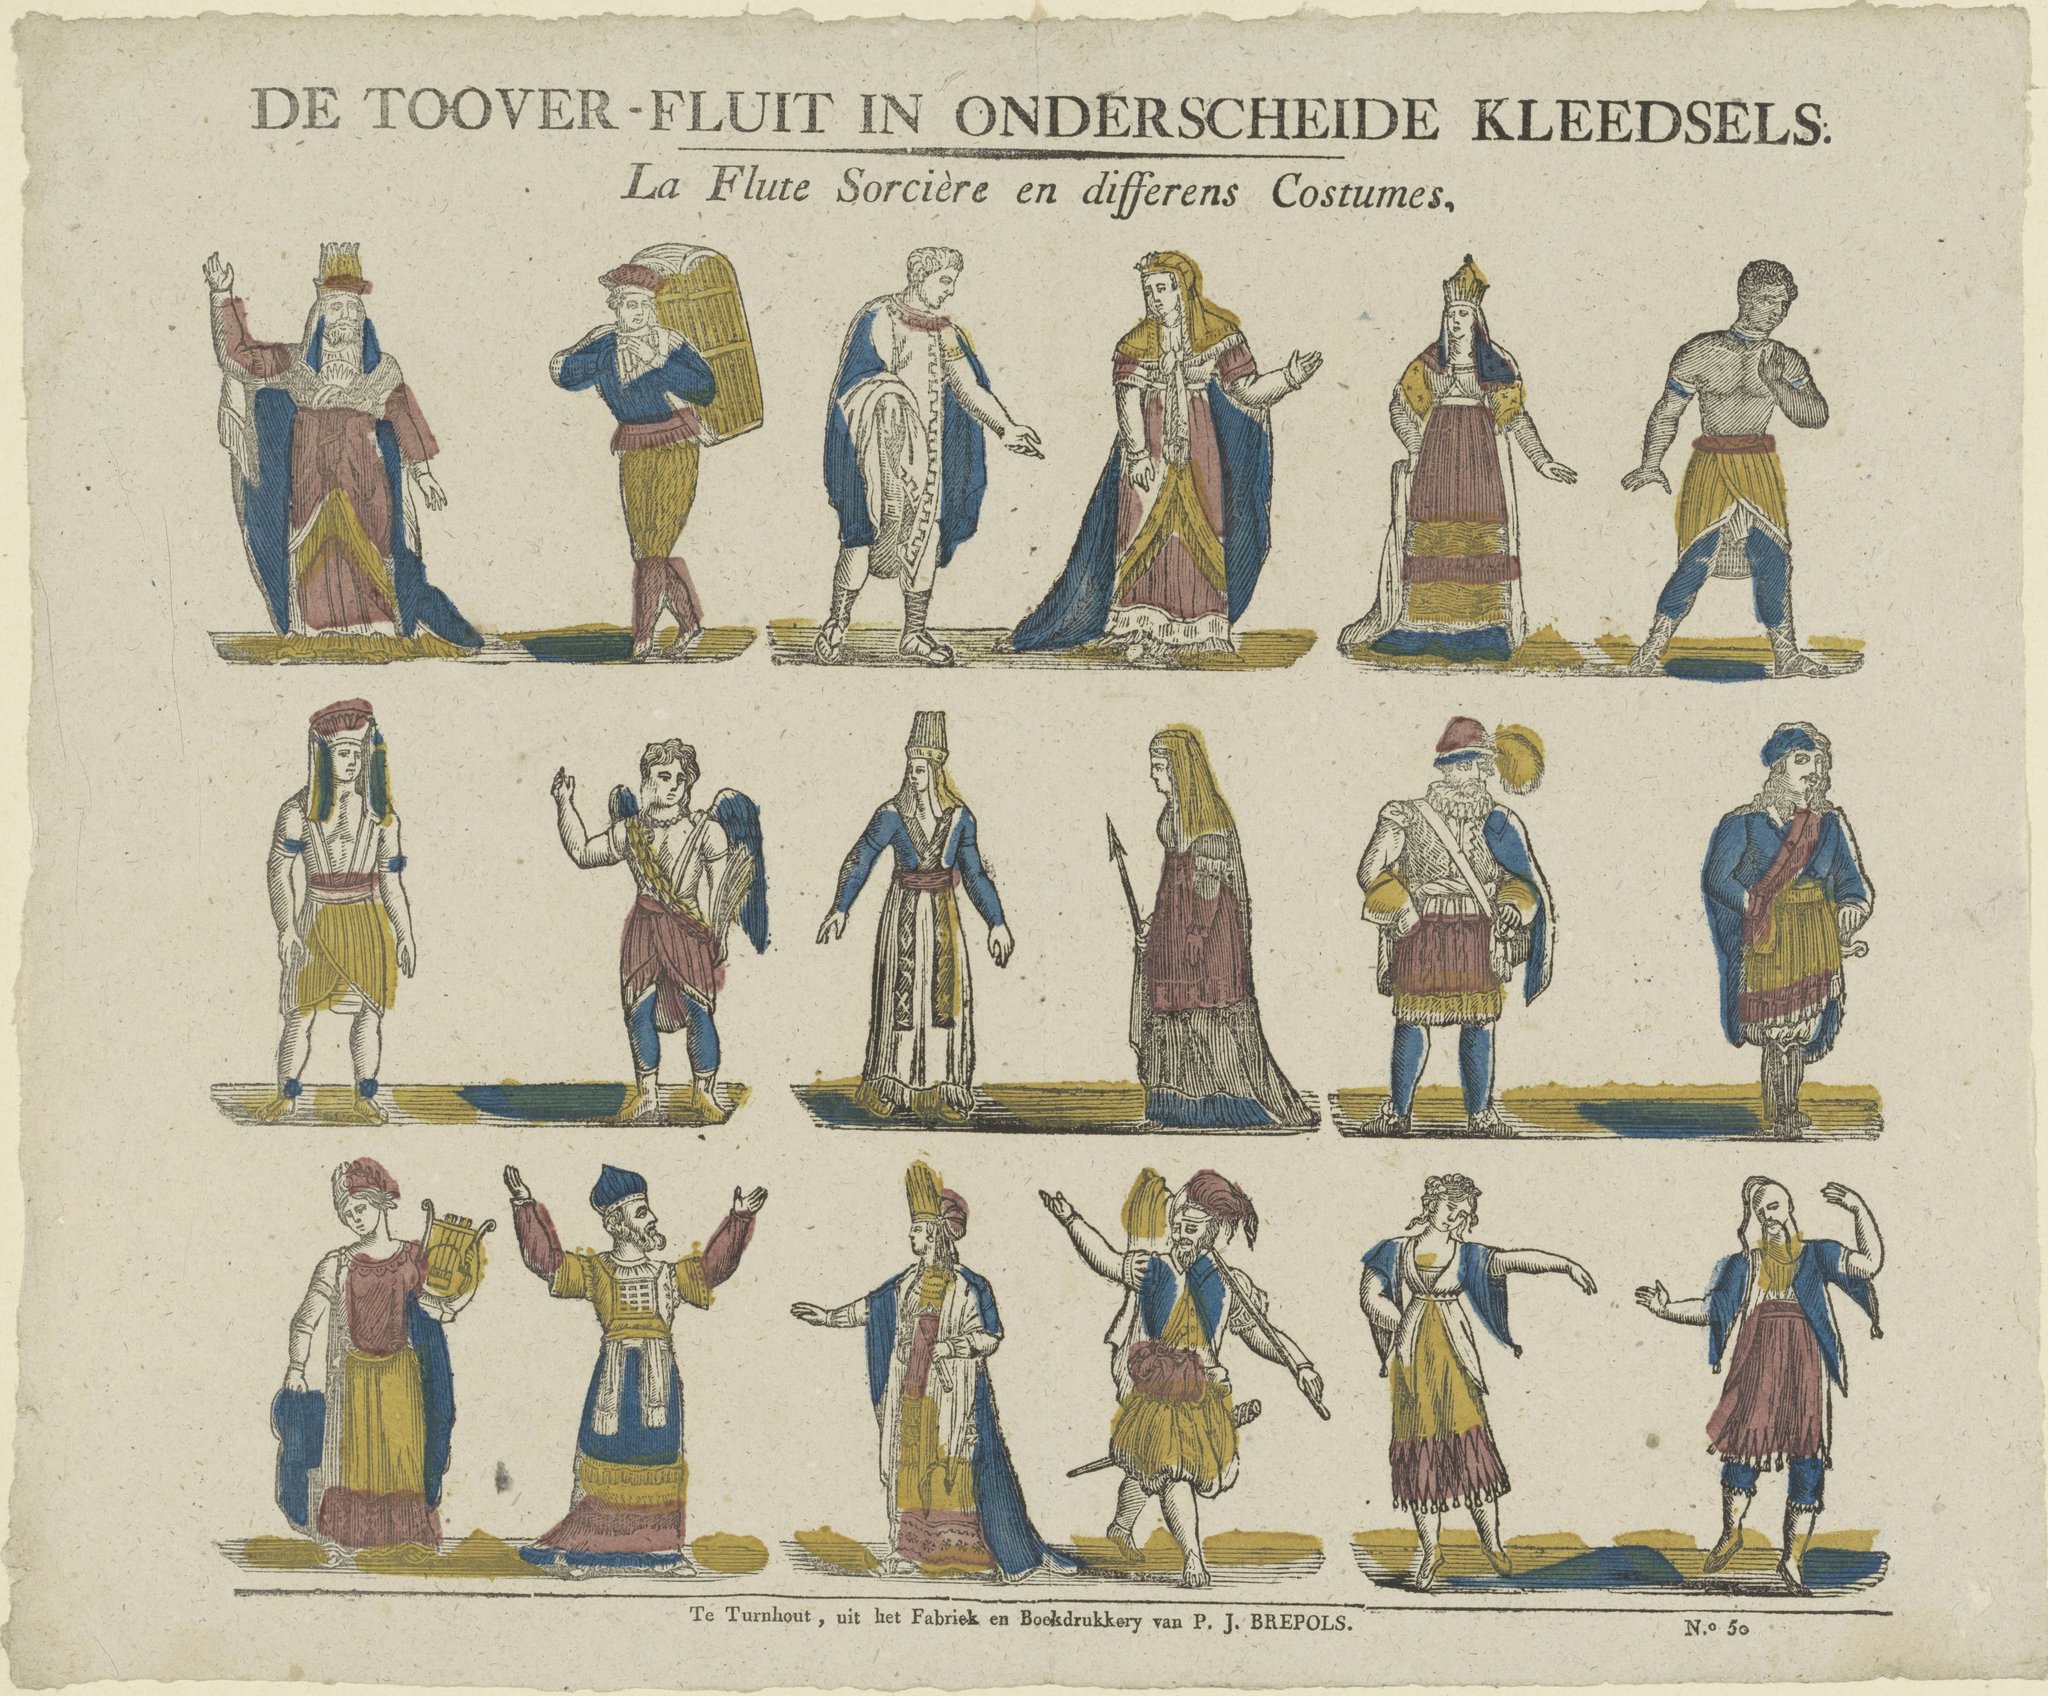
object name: popular print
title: De toover-fluit in onderscheide kleedsels / La flute sorcière en differens costumes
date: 1800-1833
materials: paper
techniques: colour, letterpress printing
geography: turnhout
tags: stage costume, opera-singer (female), opera-singer (male)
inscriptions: collector's mark: Lugt 2760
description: Blad met 3 horizontale rijen met elk zes personages uit de opera de Toverfluit (Die Zauberflöte) op een rij. Genummerd rechtsonder: No. 50.